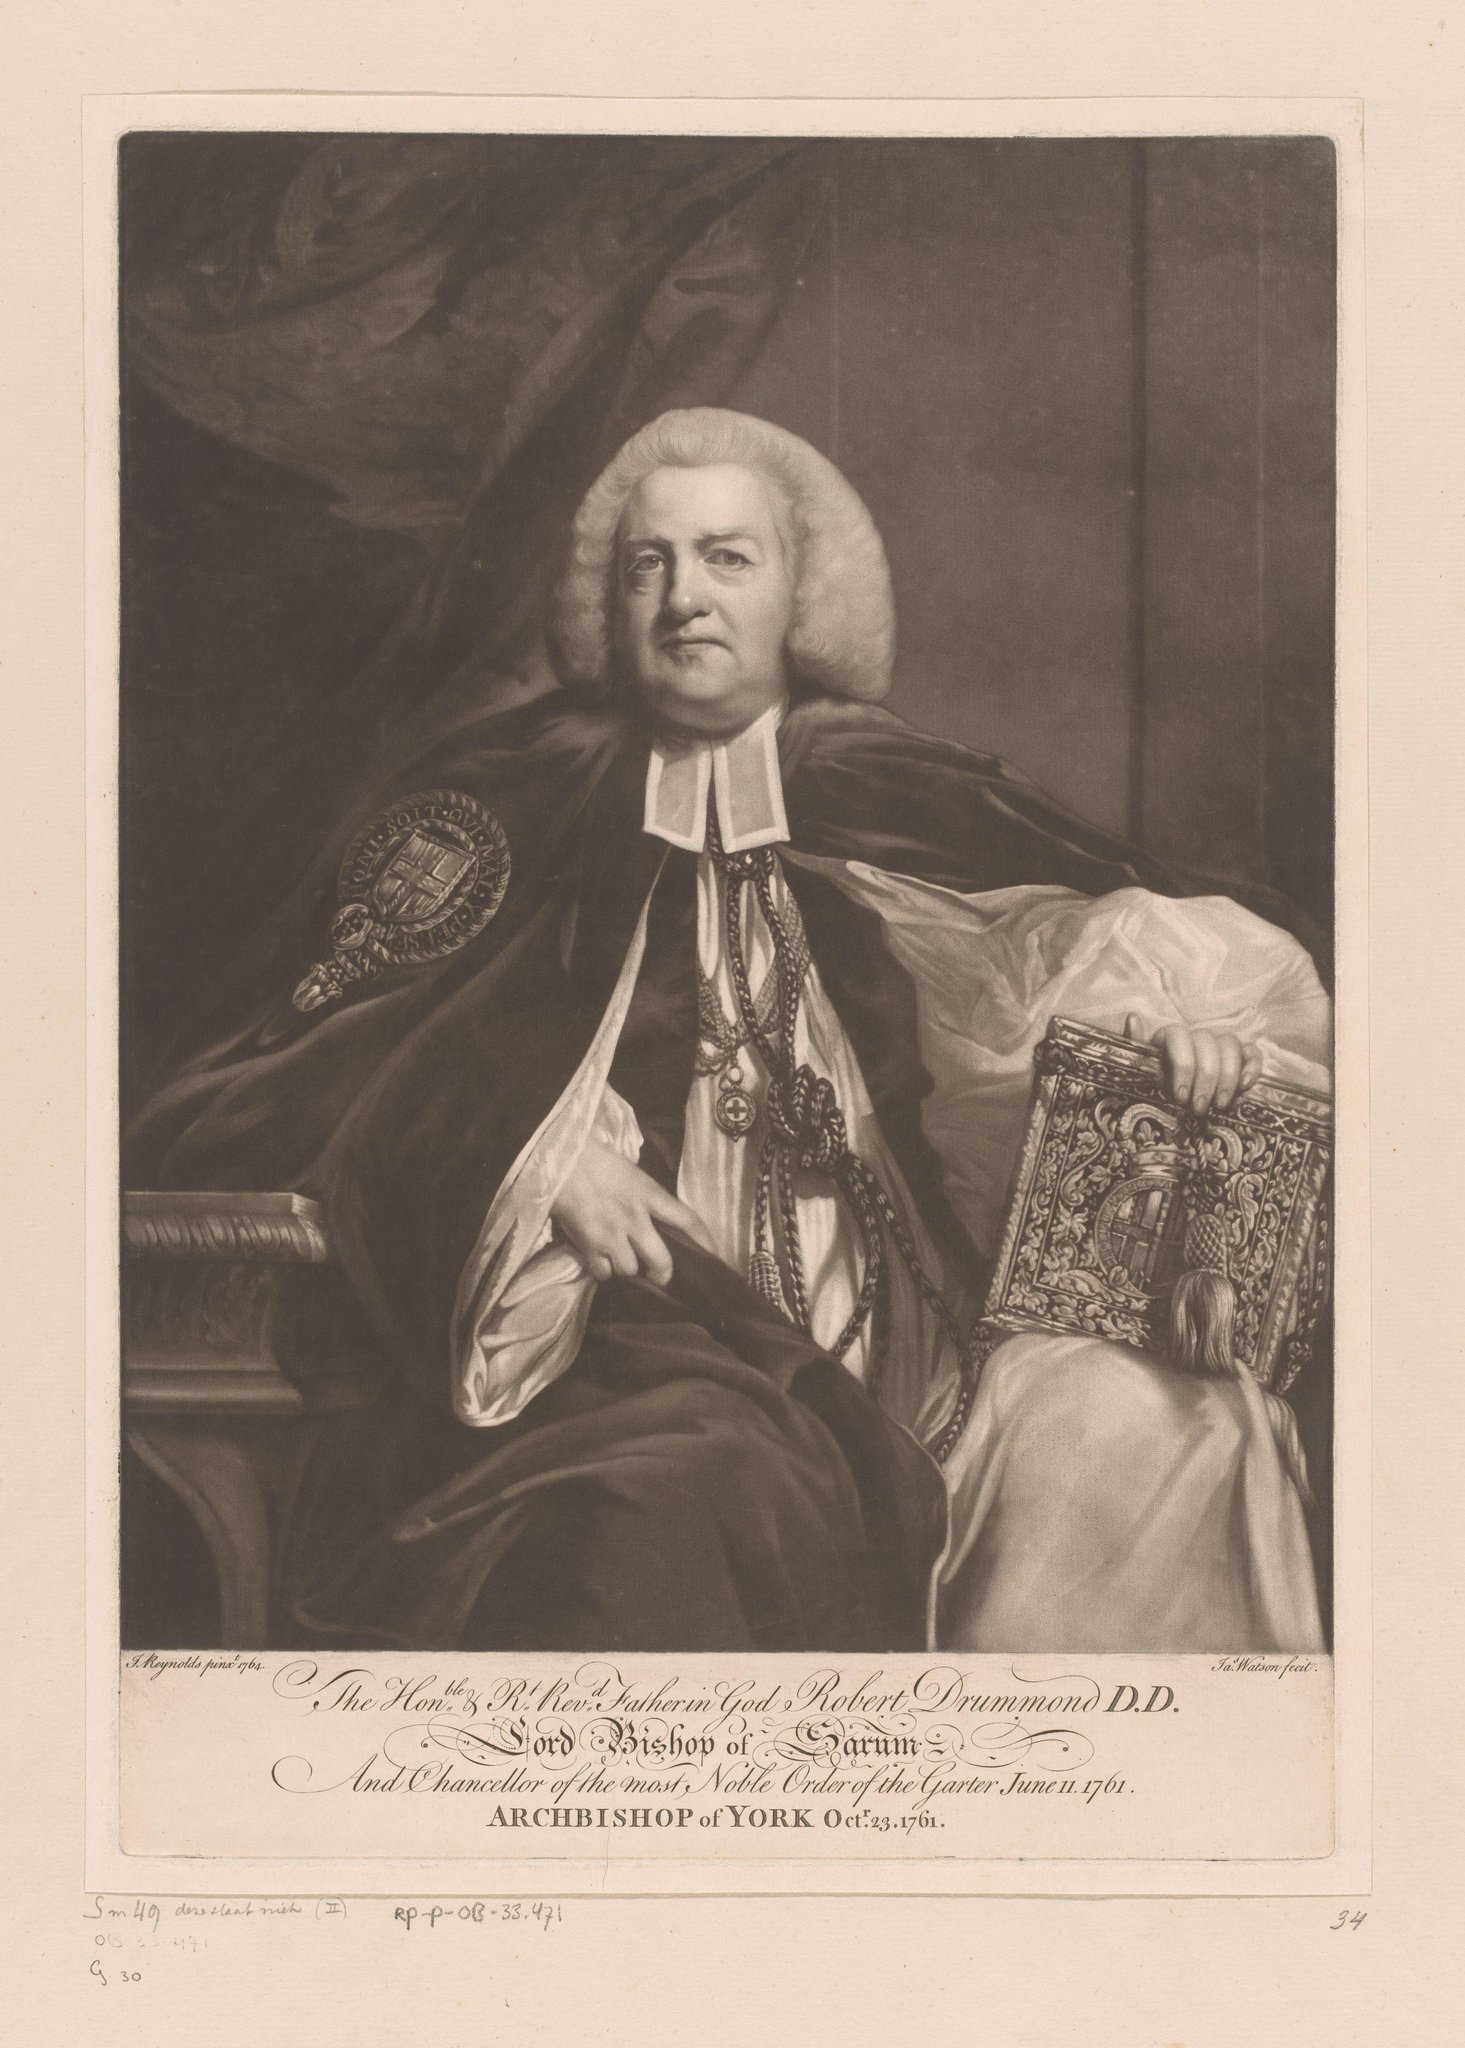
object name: print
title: Portret van Robert Drummond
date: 1764-1766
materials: paper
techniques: mezzotint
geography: london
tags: robert hay drummond, non-roman catholic episcopal churches, e.g. anglicans, historical persons, functionaries and dignitaries ~ episcopal protestant churches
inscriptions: collector's mark: Lugt 240